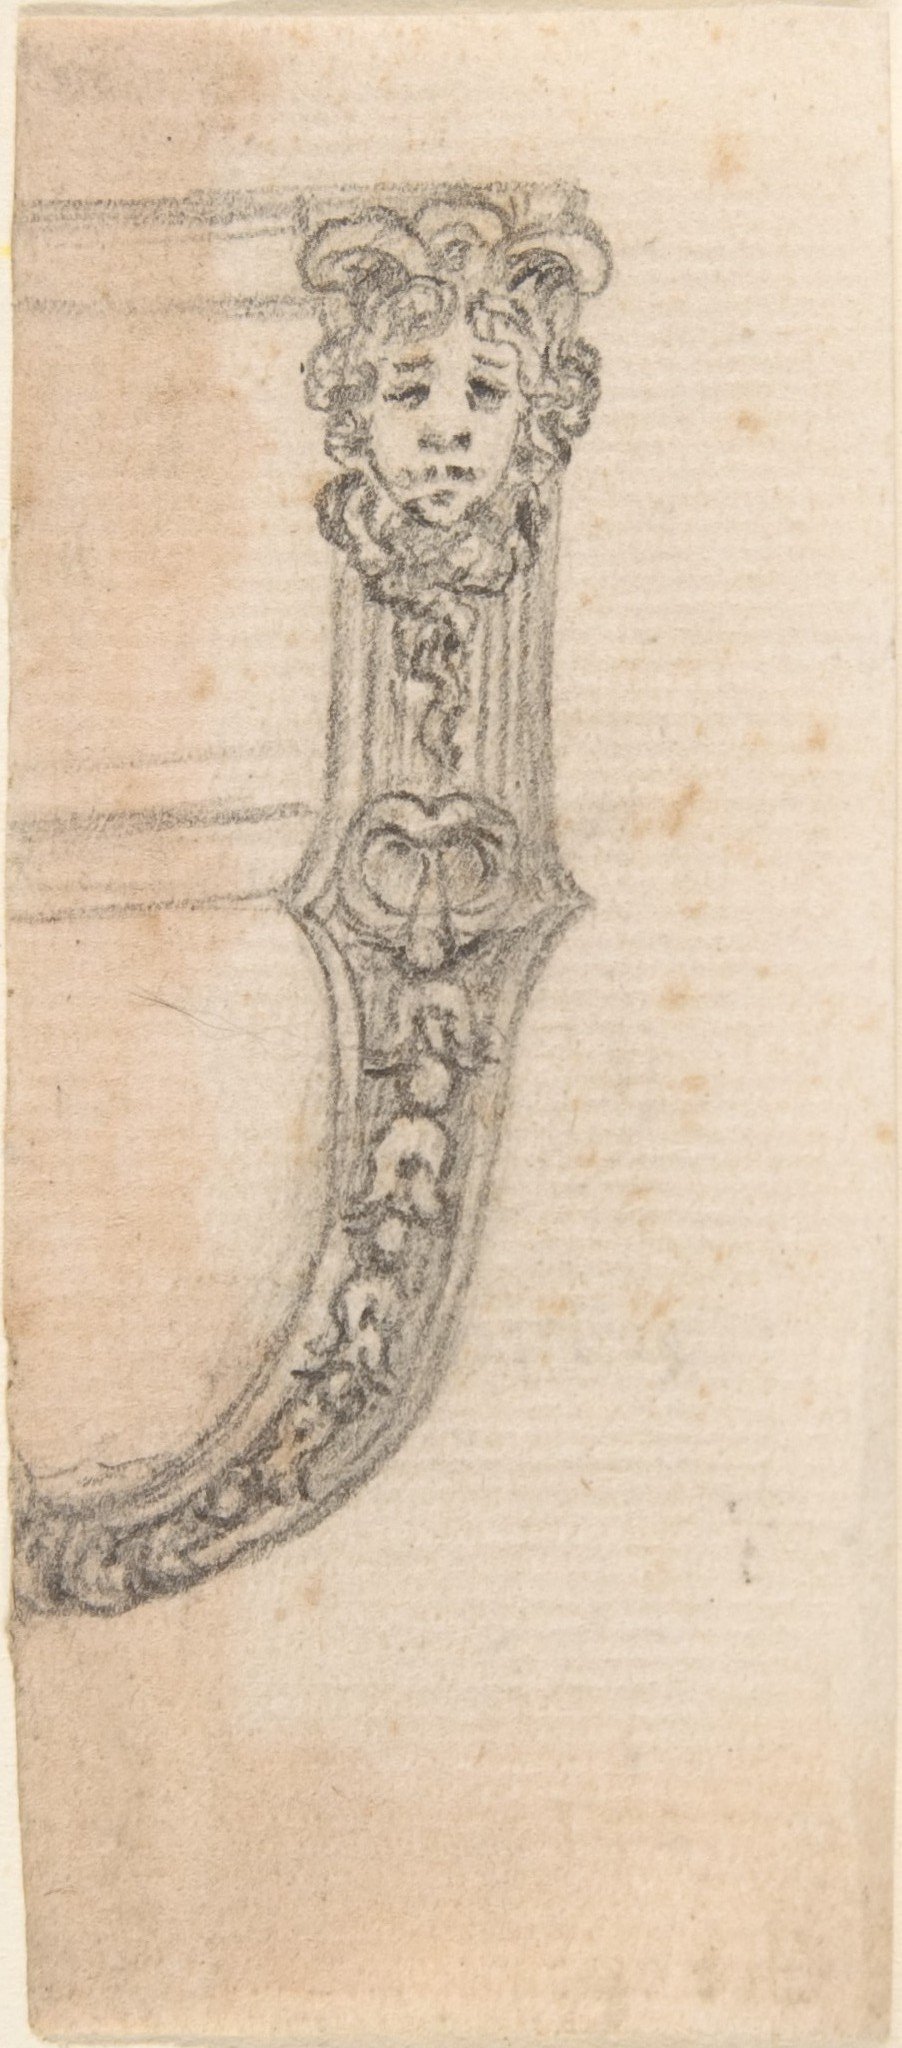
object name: drawing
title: Design for a Clasp or Buckle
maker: anonymous, italian, 17th or 18th century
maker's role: artist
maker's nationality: italian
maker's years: 1600-1799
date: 1601-1800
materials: chalk, graphite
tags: buckles,ornament